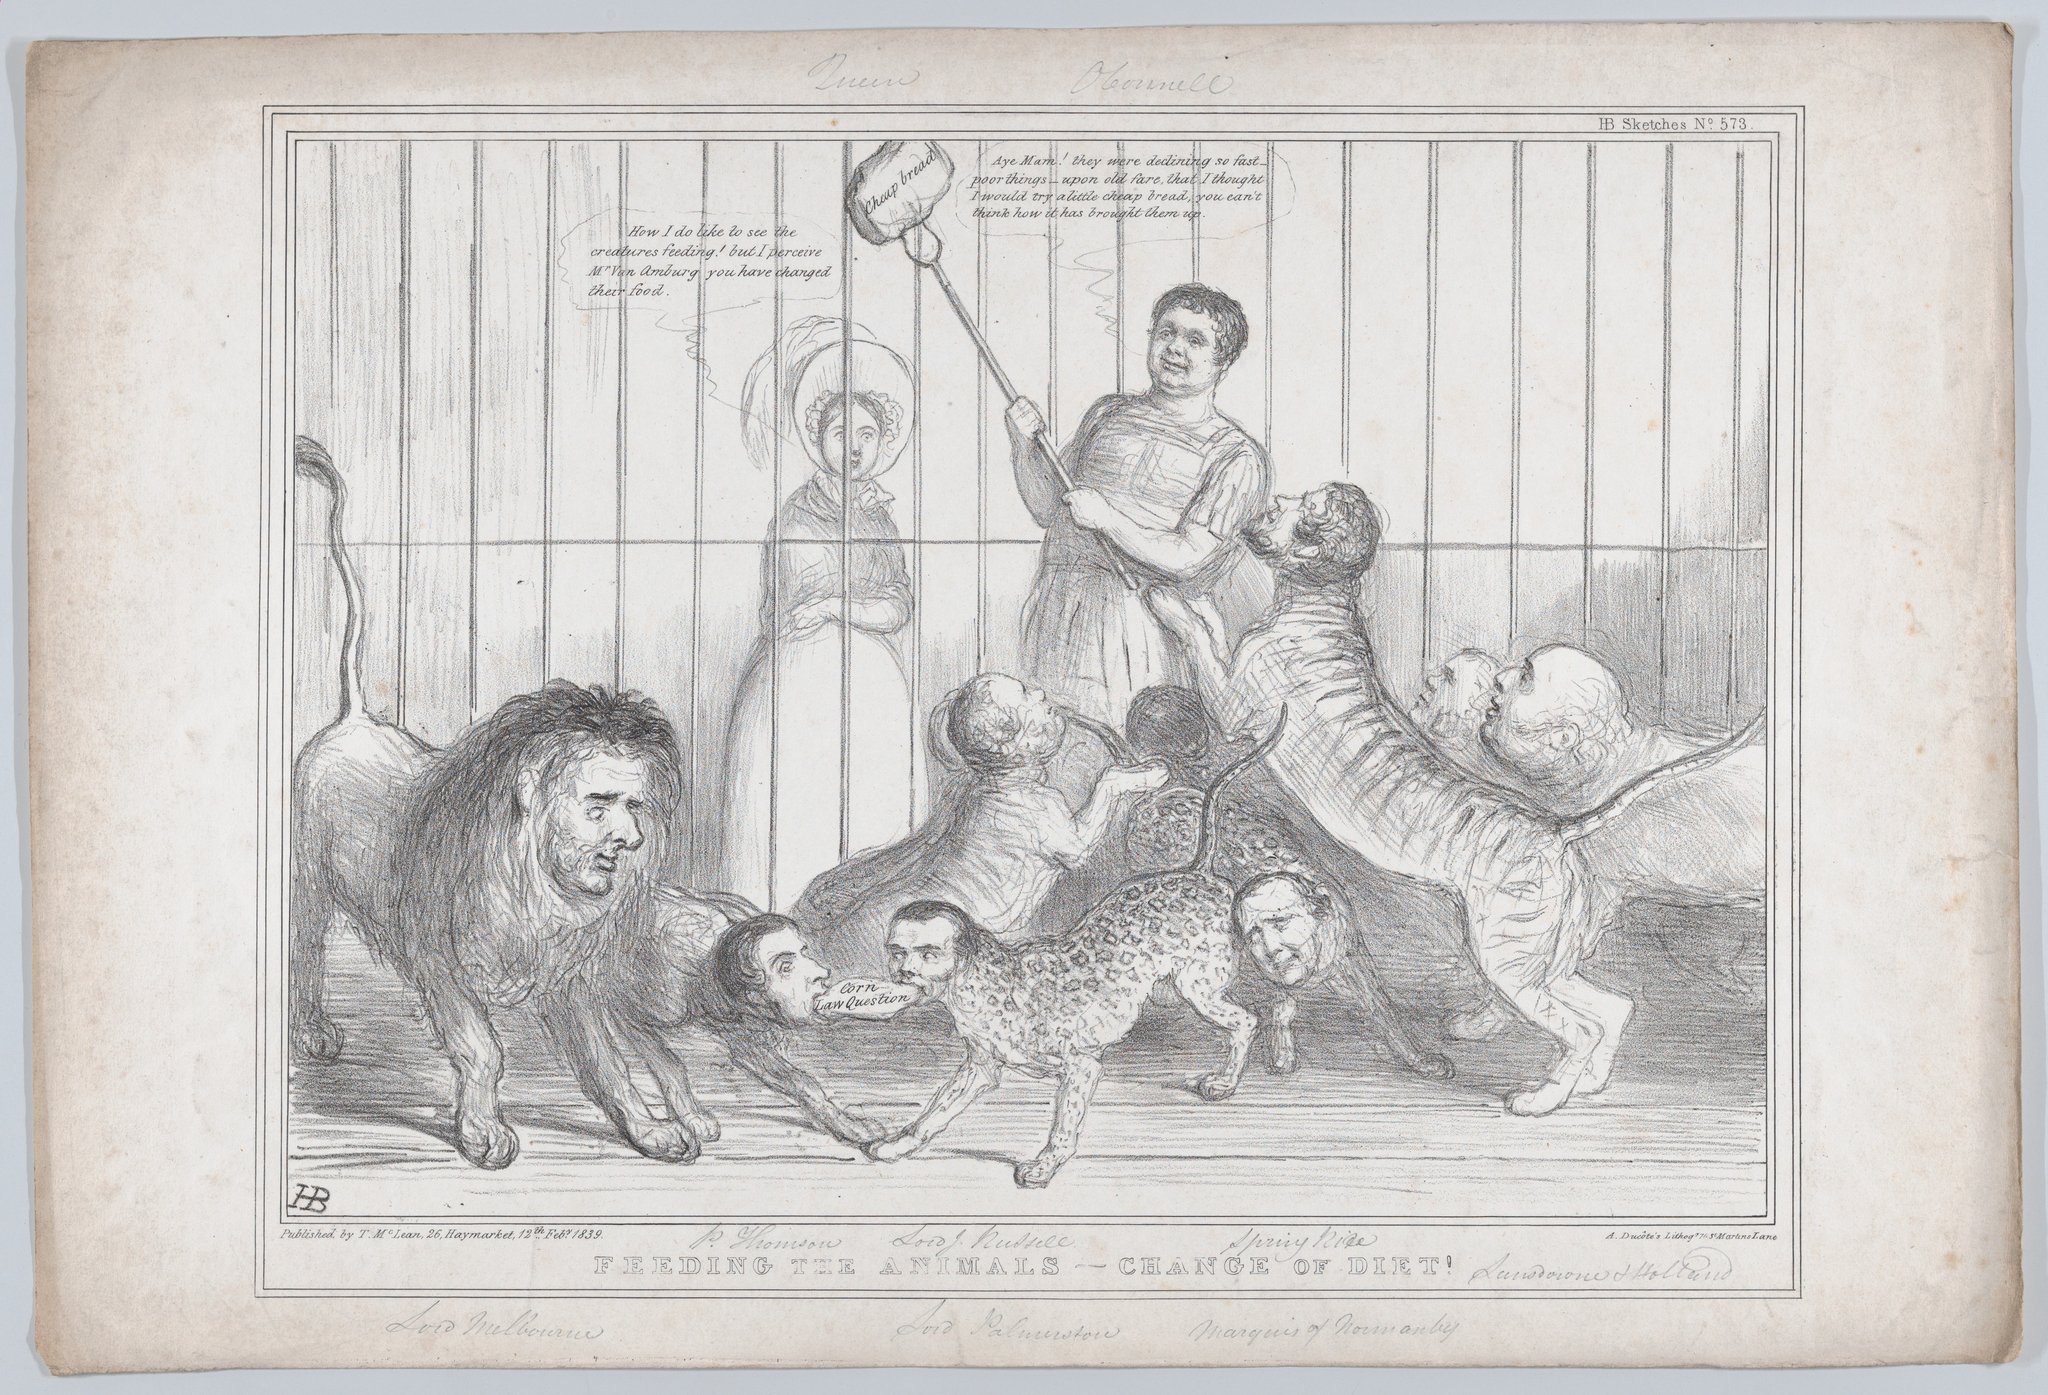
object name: print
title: Feeding the Animals – A Change of Diet!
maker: john doyle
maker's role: artist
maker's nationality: irish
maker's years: 1797-1868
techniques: lithograph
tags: men,women,caricature,politics,queen victoria